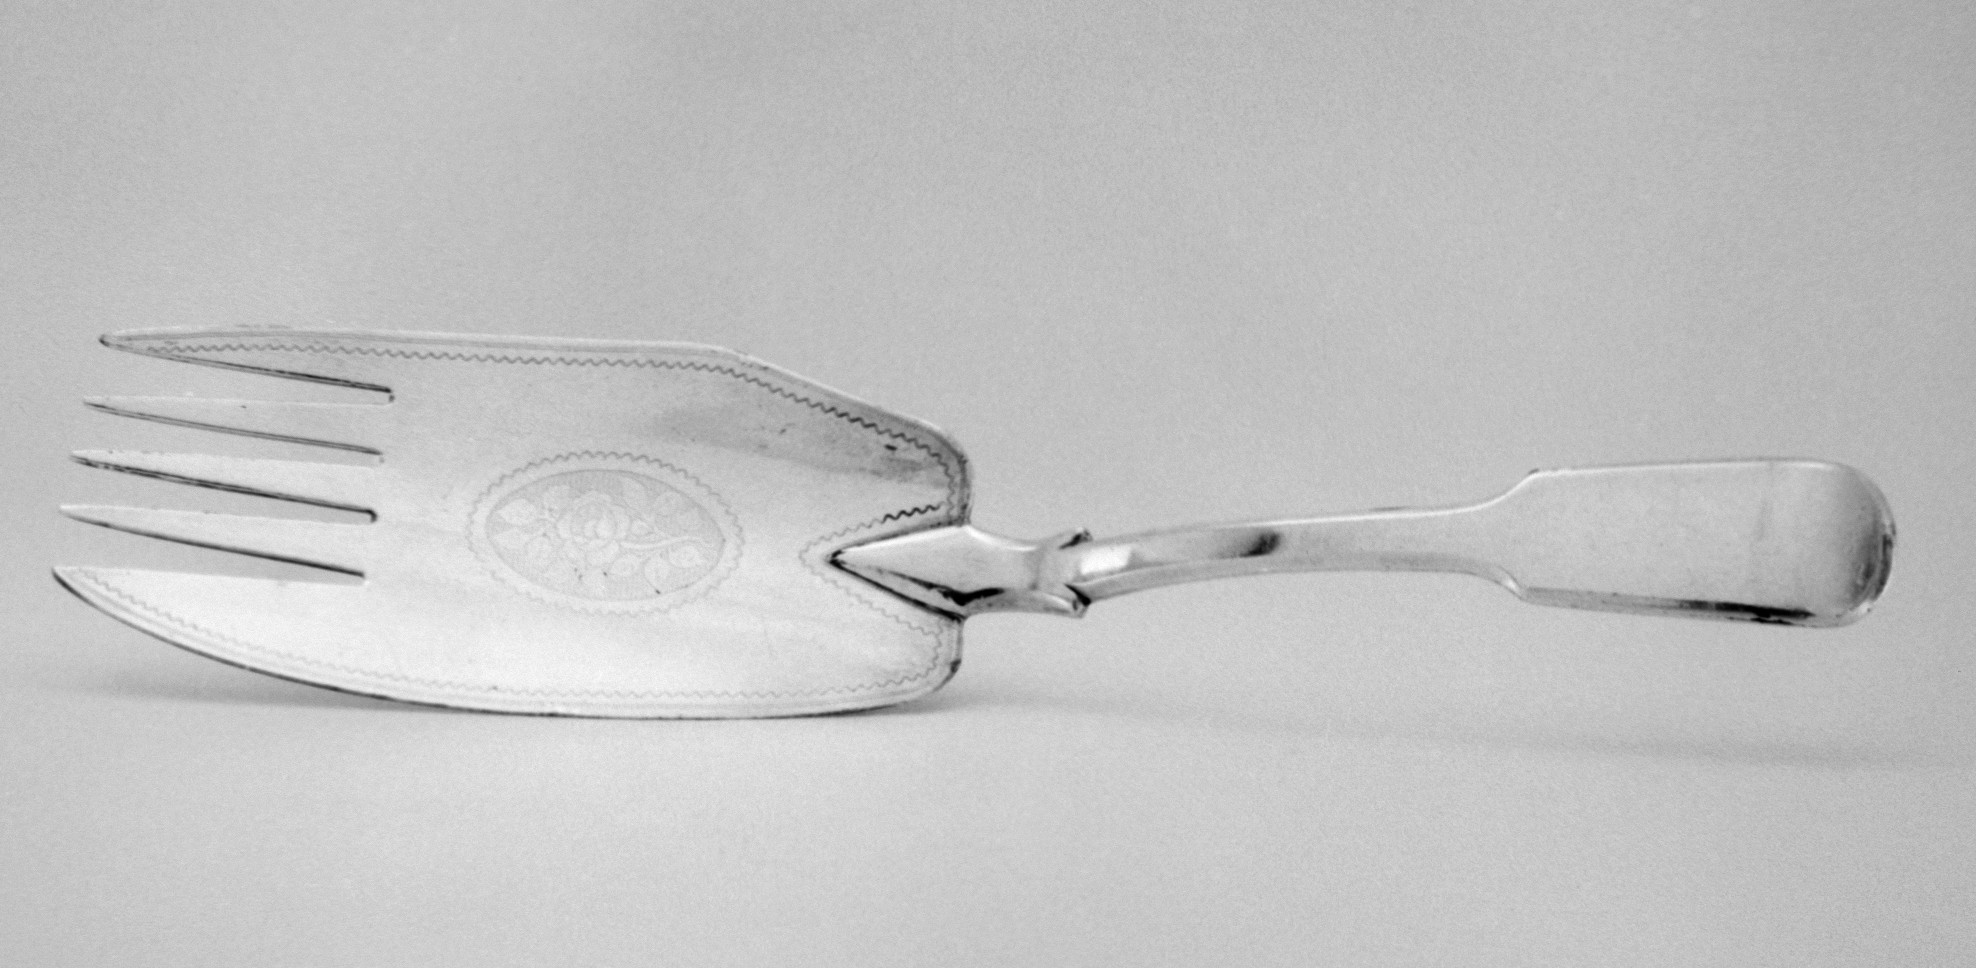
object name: server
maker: g. gibbs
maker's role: maker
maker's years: 1750-1850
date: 1808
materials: metal